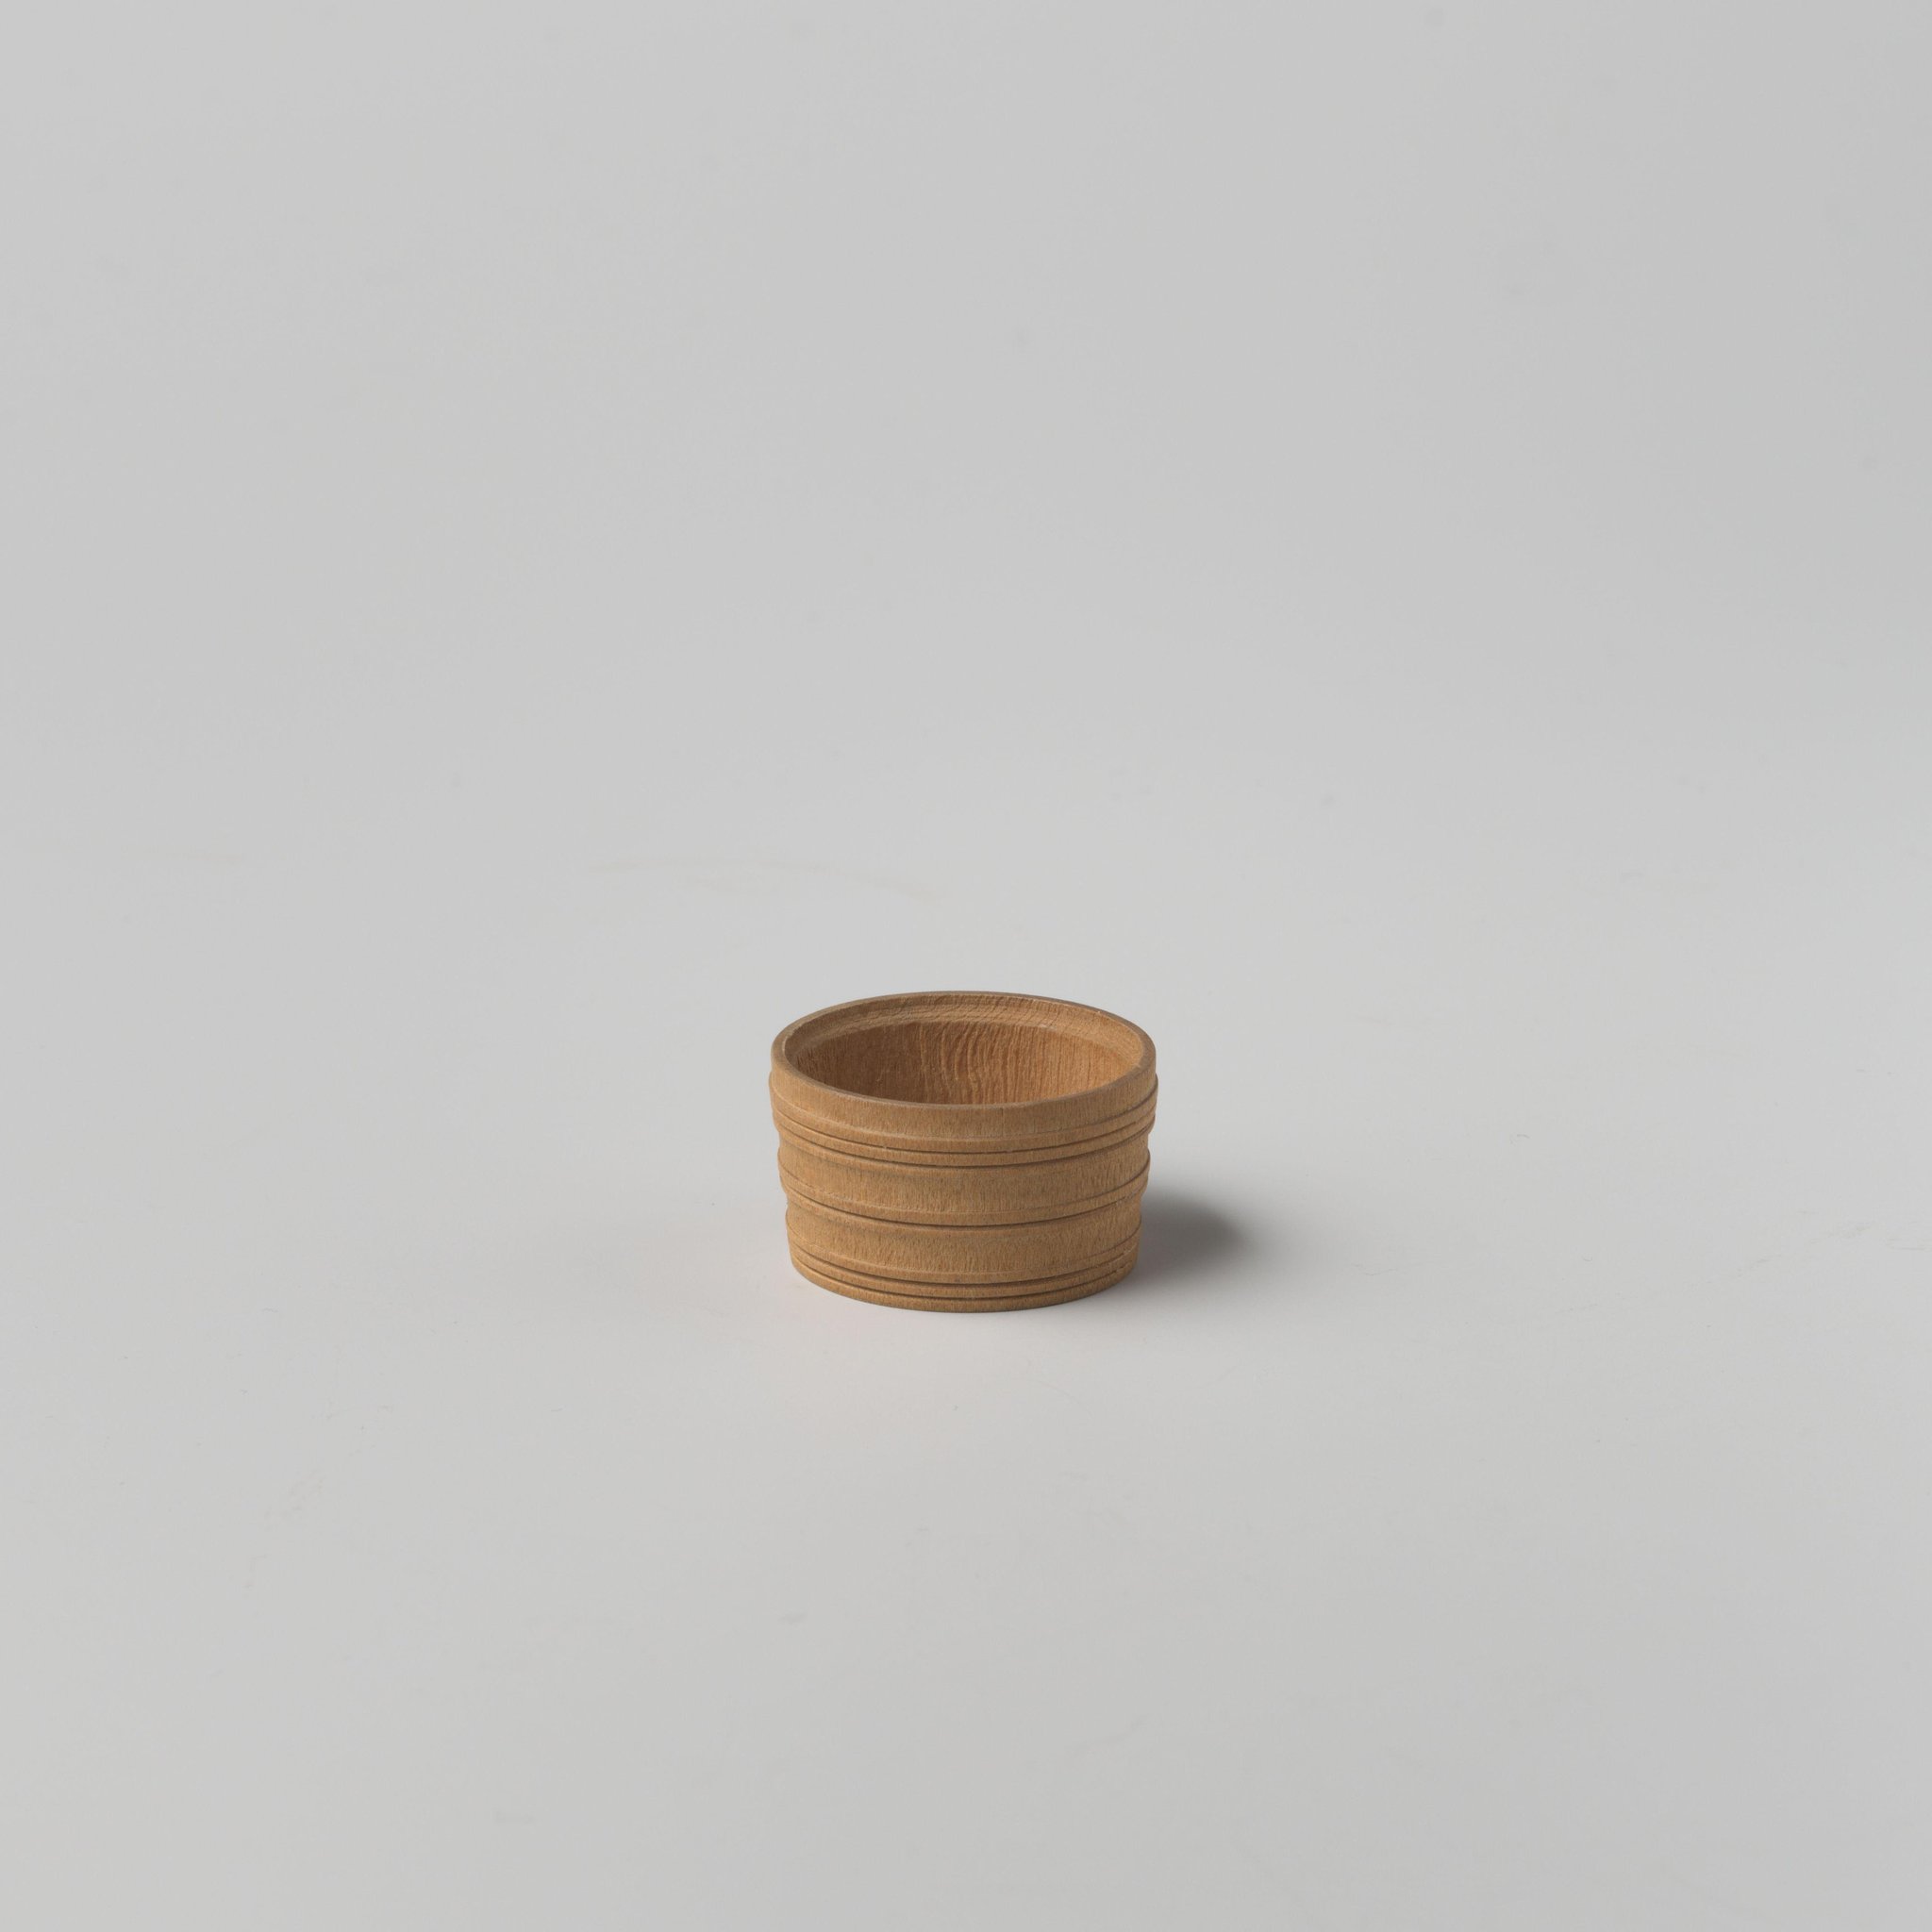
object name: tub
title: Wastobbe van esdoornhout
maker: Anonymous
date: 1676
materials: wood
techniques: turning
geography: amsterdam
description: Wastobbe, gedraaid van esdoornhout, met ringen (hoepels voorstellende).